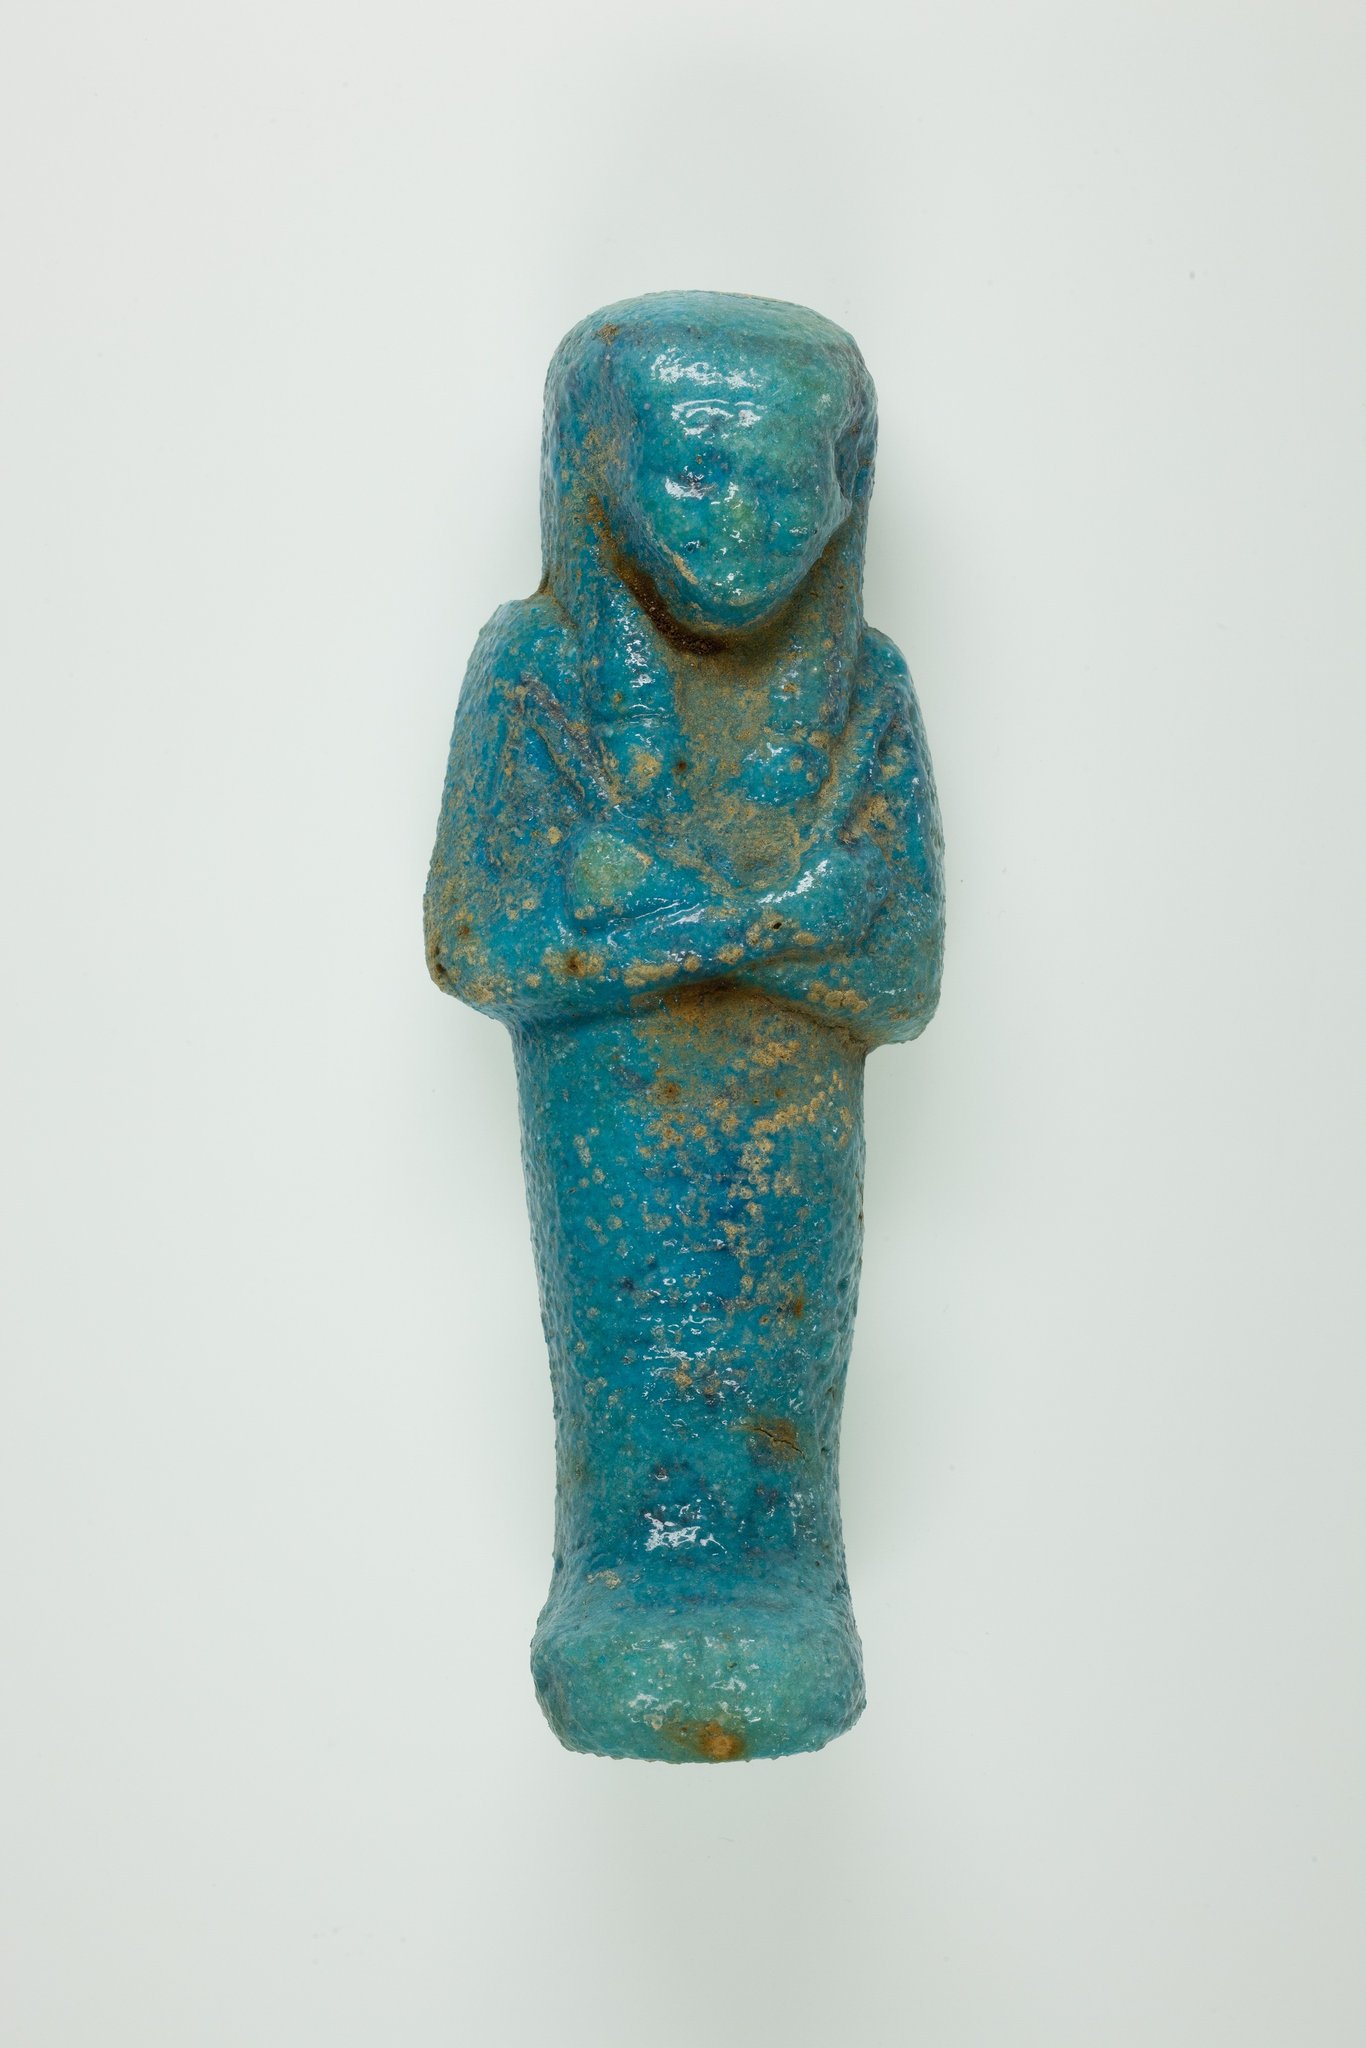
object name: worker shabti, henettawy c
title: Worker Shabti of Henettawy (C), Daughter of Isetemkheb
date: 990-970 BCE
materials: faience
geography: egypt